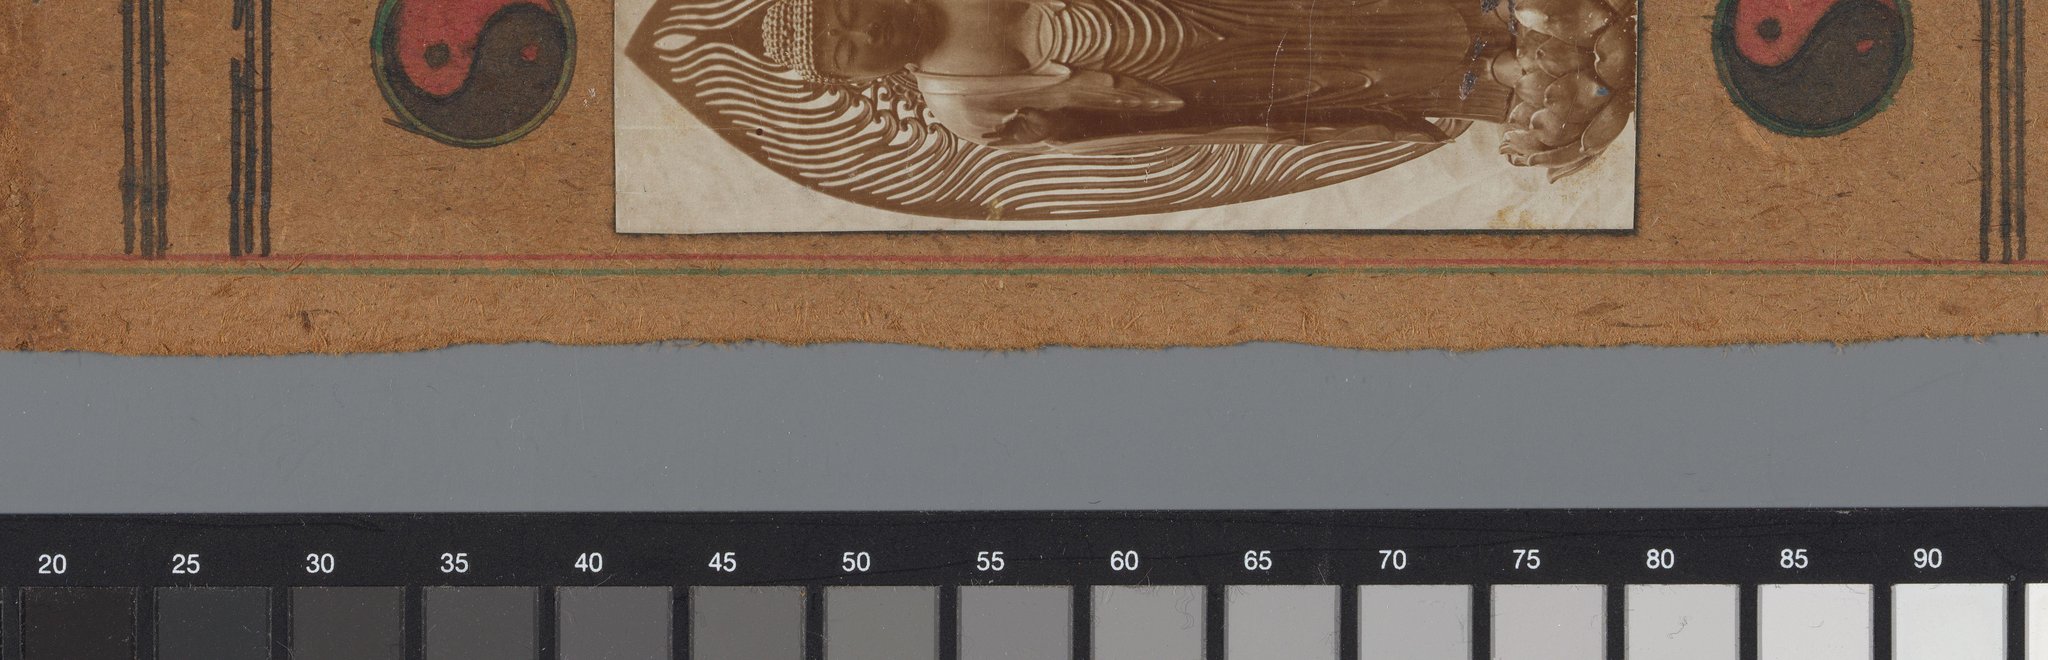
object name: photograph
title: Boeddhabeeld op lotus, op bladwijzer met yin-yangsymbolen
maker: Anonymous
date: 1880-1930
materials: paper, cardboard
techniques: drawing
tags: ornament ~ yin-yang, buddha, founder of buddhism